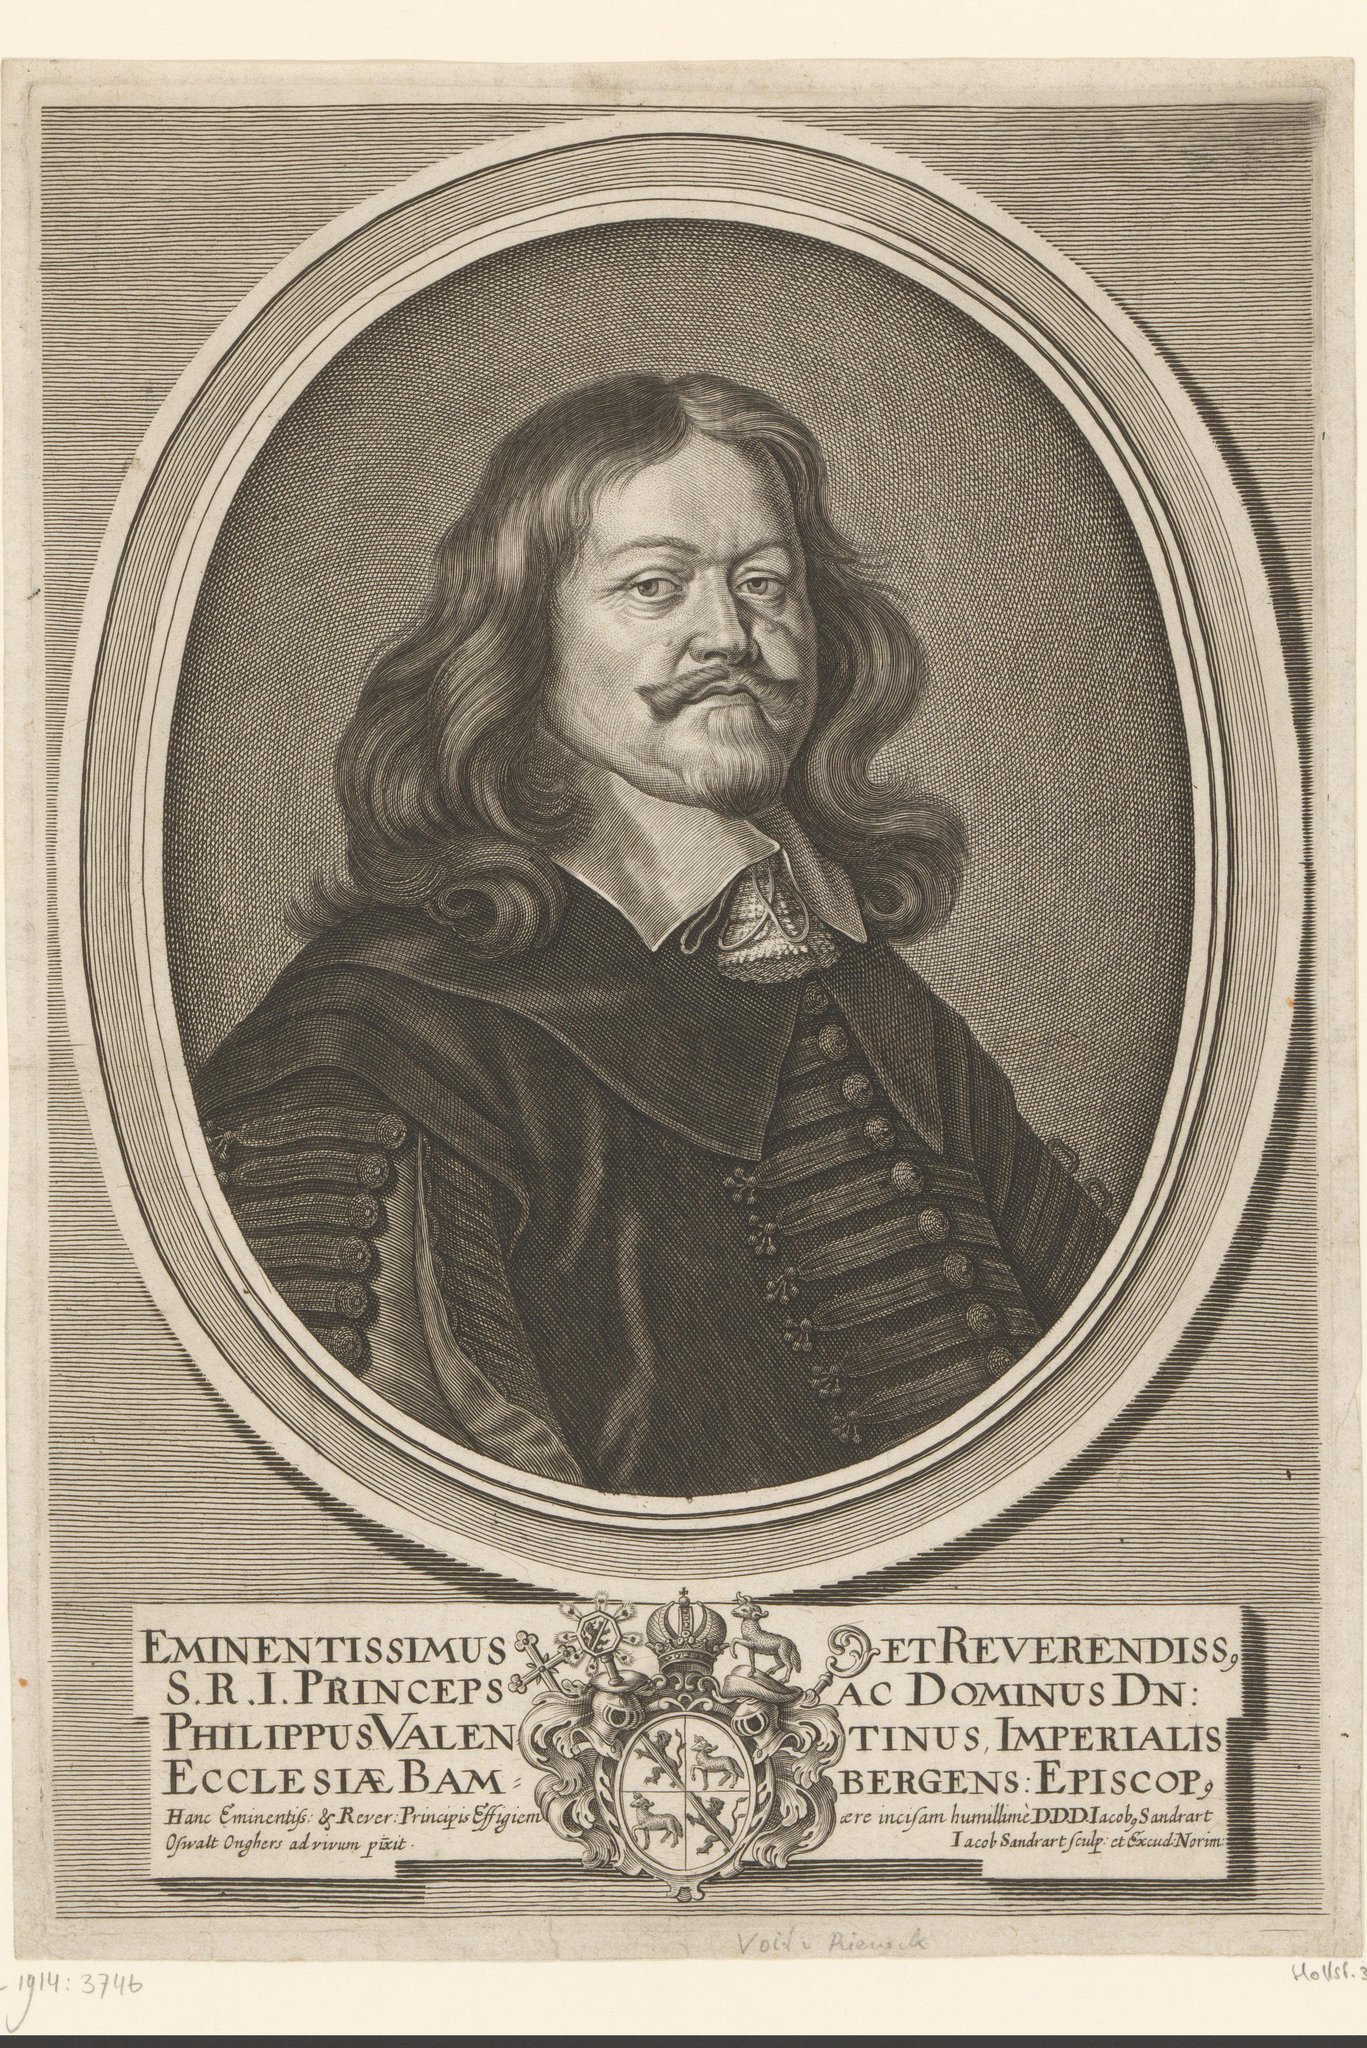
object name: print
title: Portret van Philipp Valentin Voit von Rieneck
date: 1660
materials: paper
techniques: engraving, etching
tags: historical persons, armorial bearing, heraldry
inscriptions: collector's mark: Lugt 2228